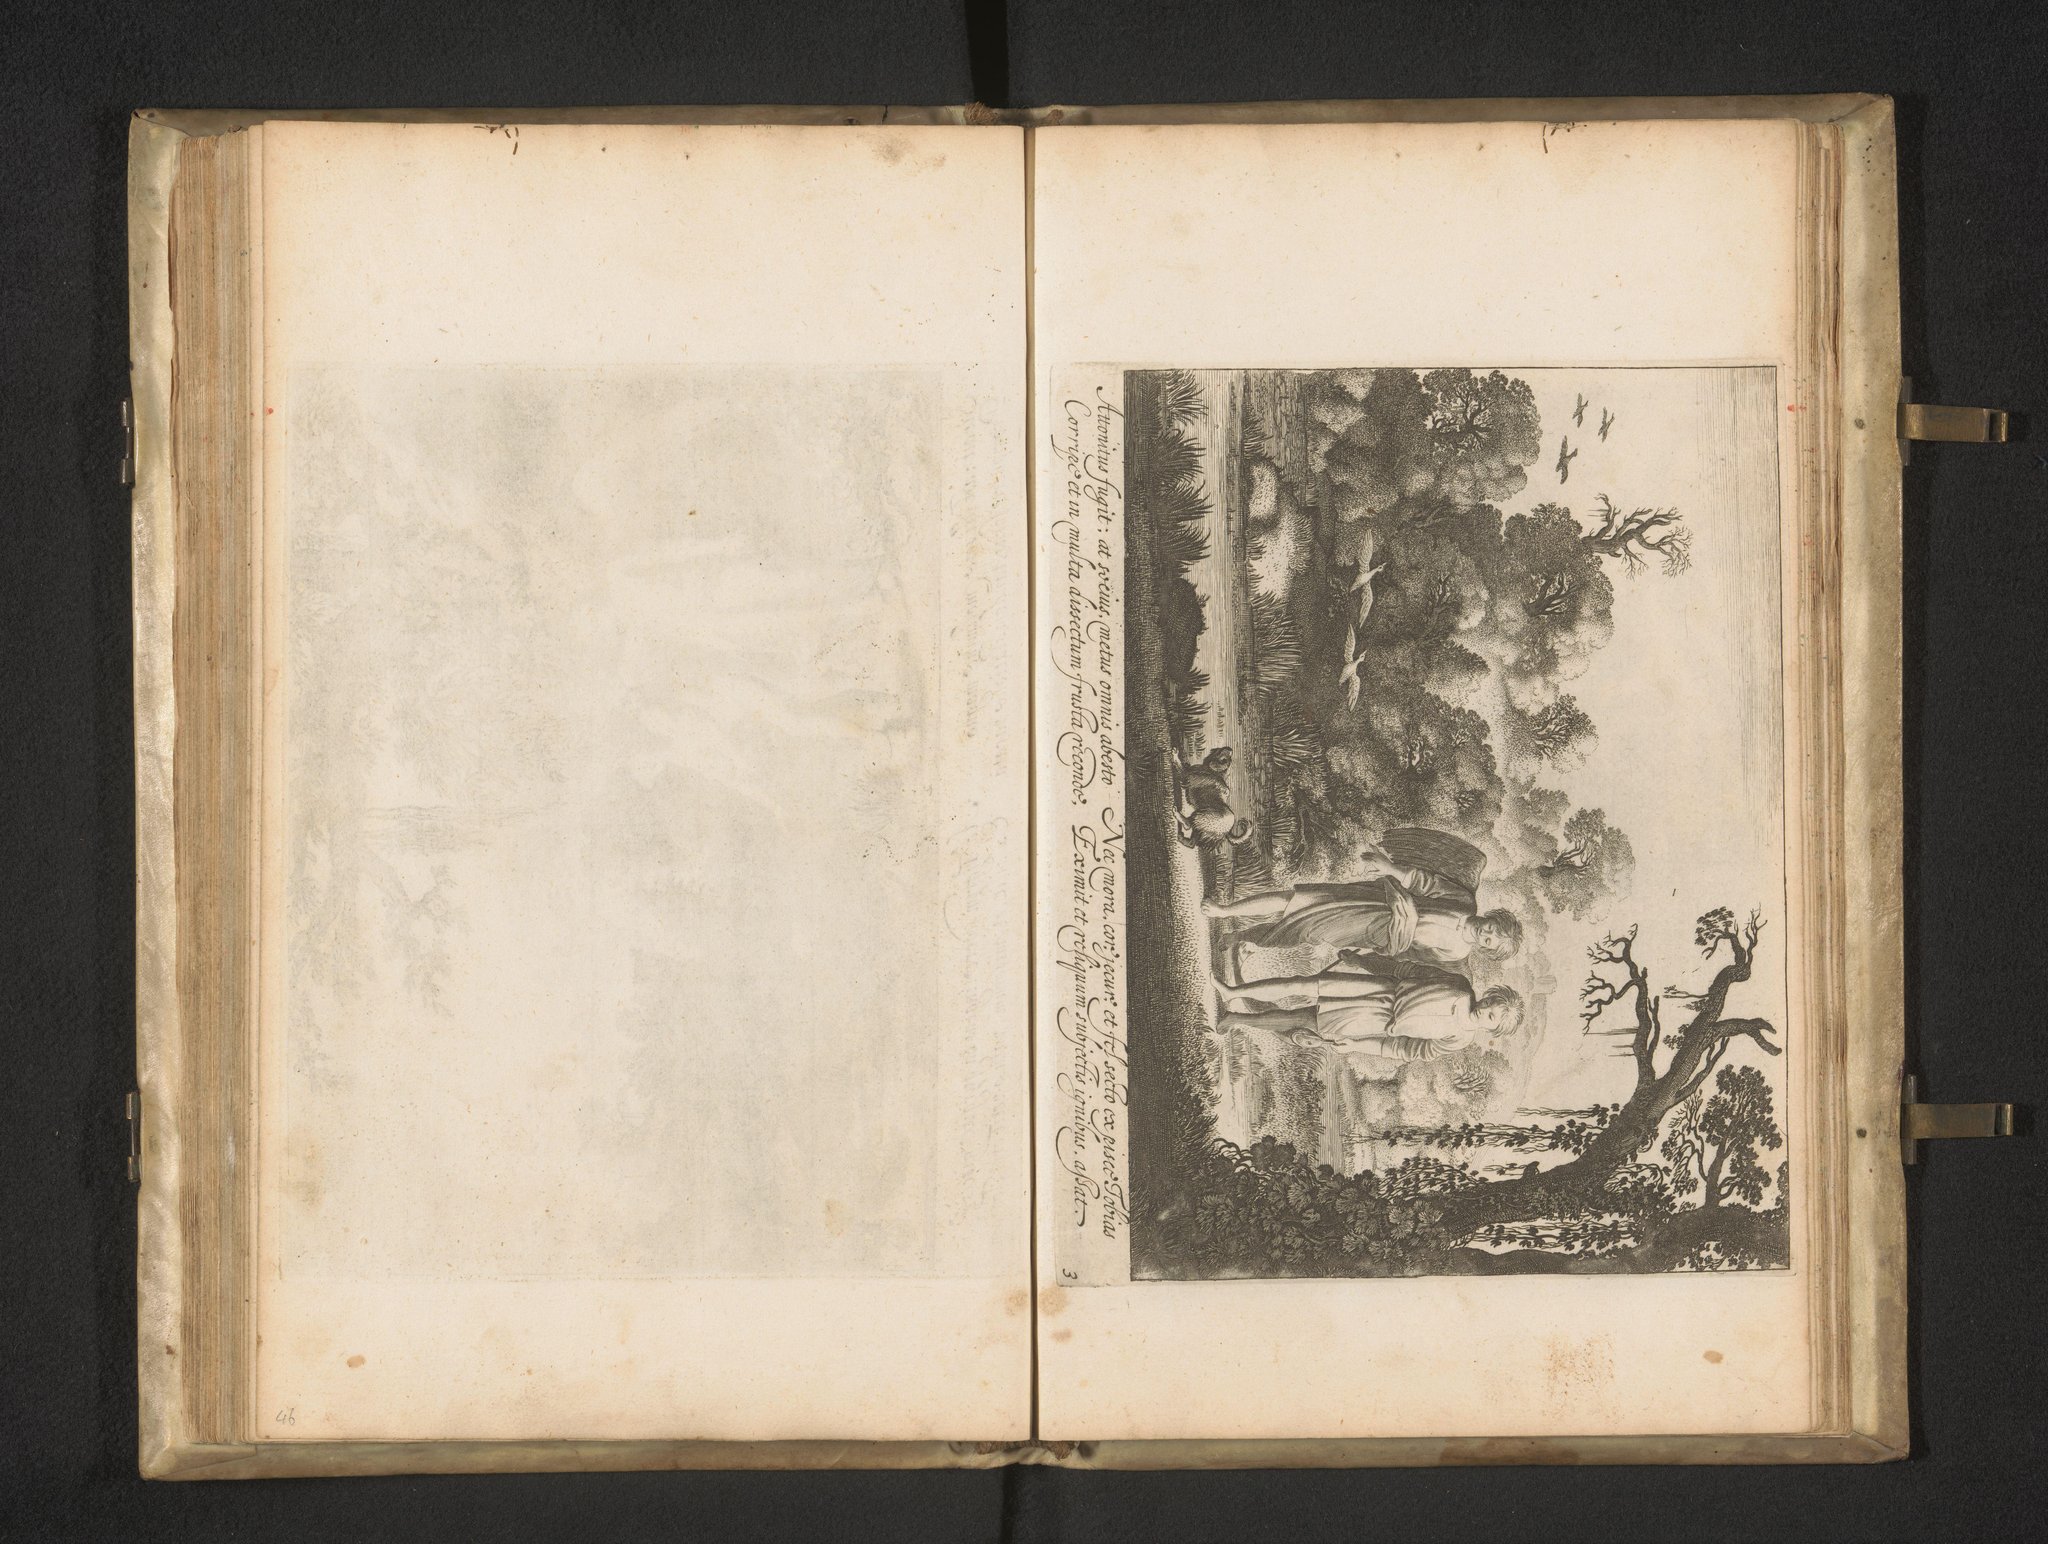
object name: print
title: Verhaal van Tobias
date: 1603-1641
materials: paper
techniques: engraving, etching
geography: amsterdam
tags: tobias and the angel raphael continue their journey; usually tobias carrying the fish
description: Tobias en de engel Rafaël vervolgen hun reis, Tobias draagt de door hem gevangen vis. Derde prent uit een serie van vier over het bijbelverhaal van Tobias. Rechtsonder genummerd: 3. Onderaan in de marge een onderschrift van vier regels in het Latijn. Onderdeel van een album met voornamelijk christelijke voorstellingen.